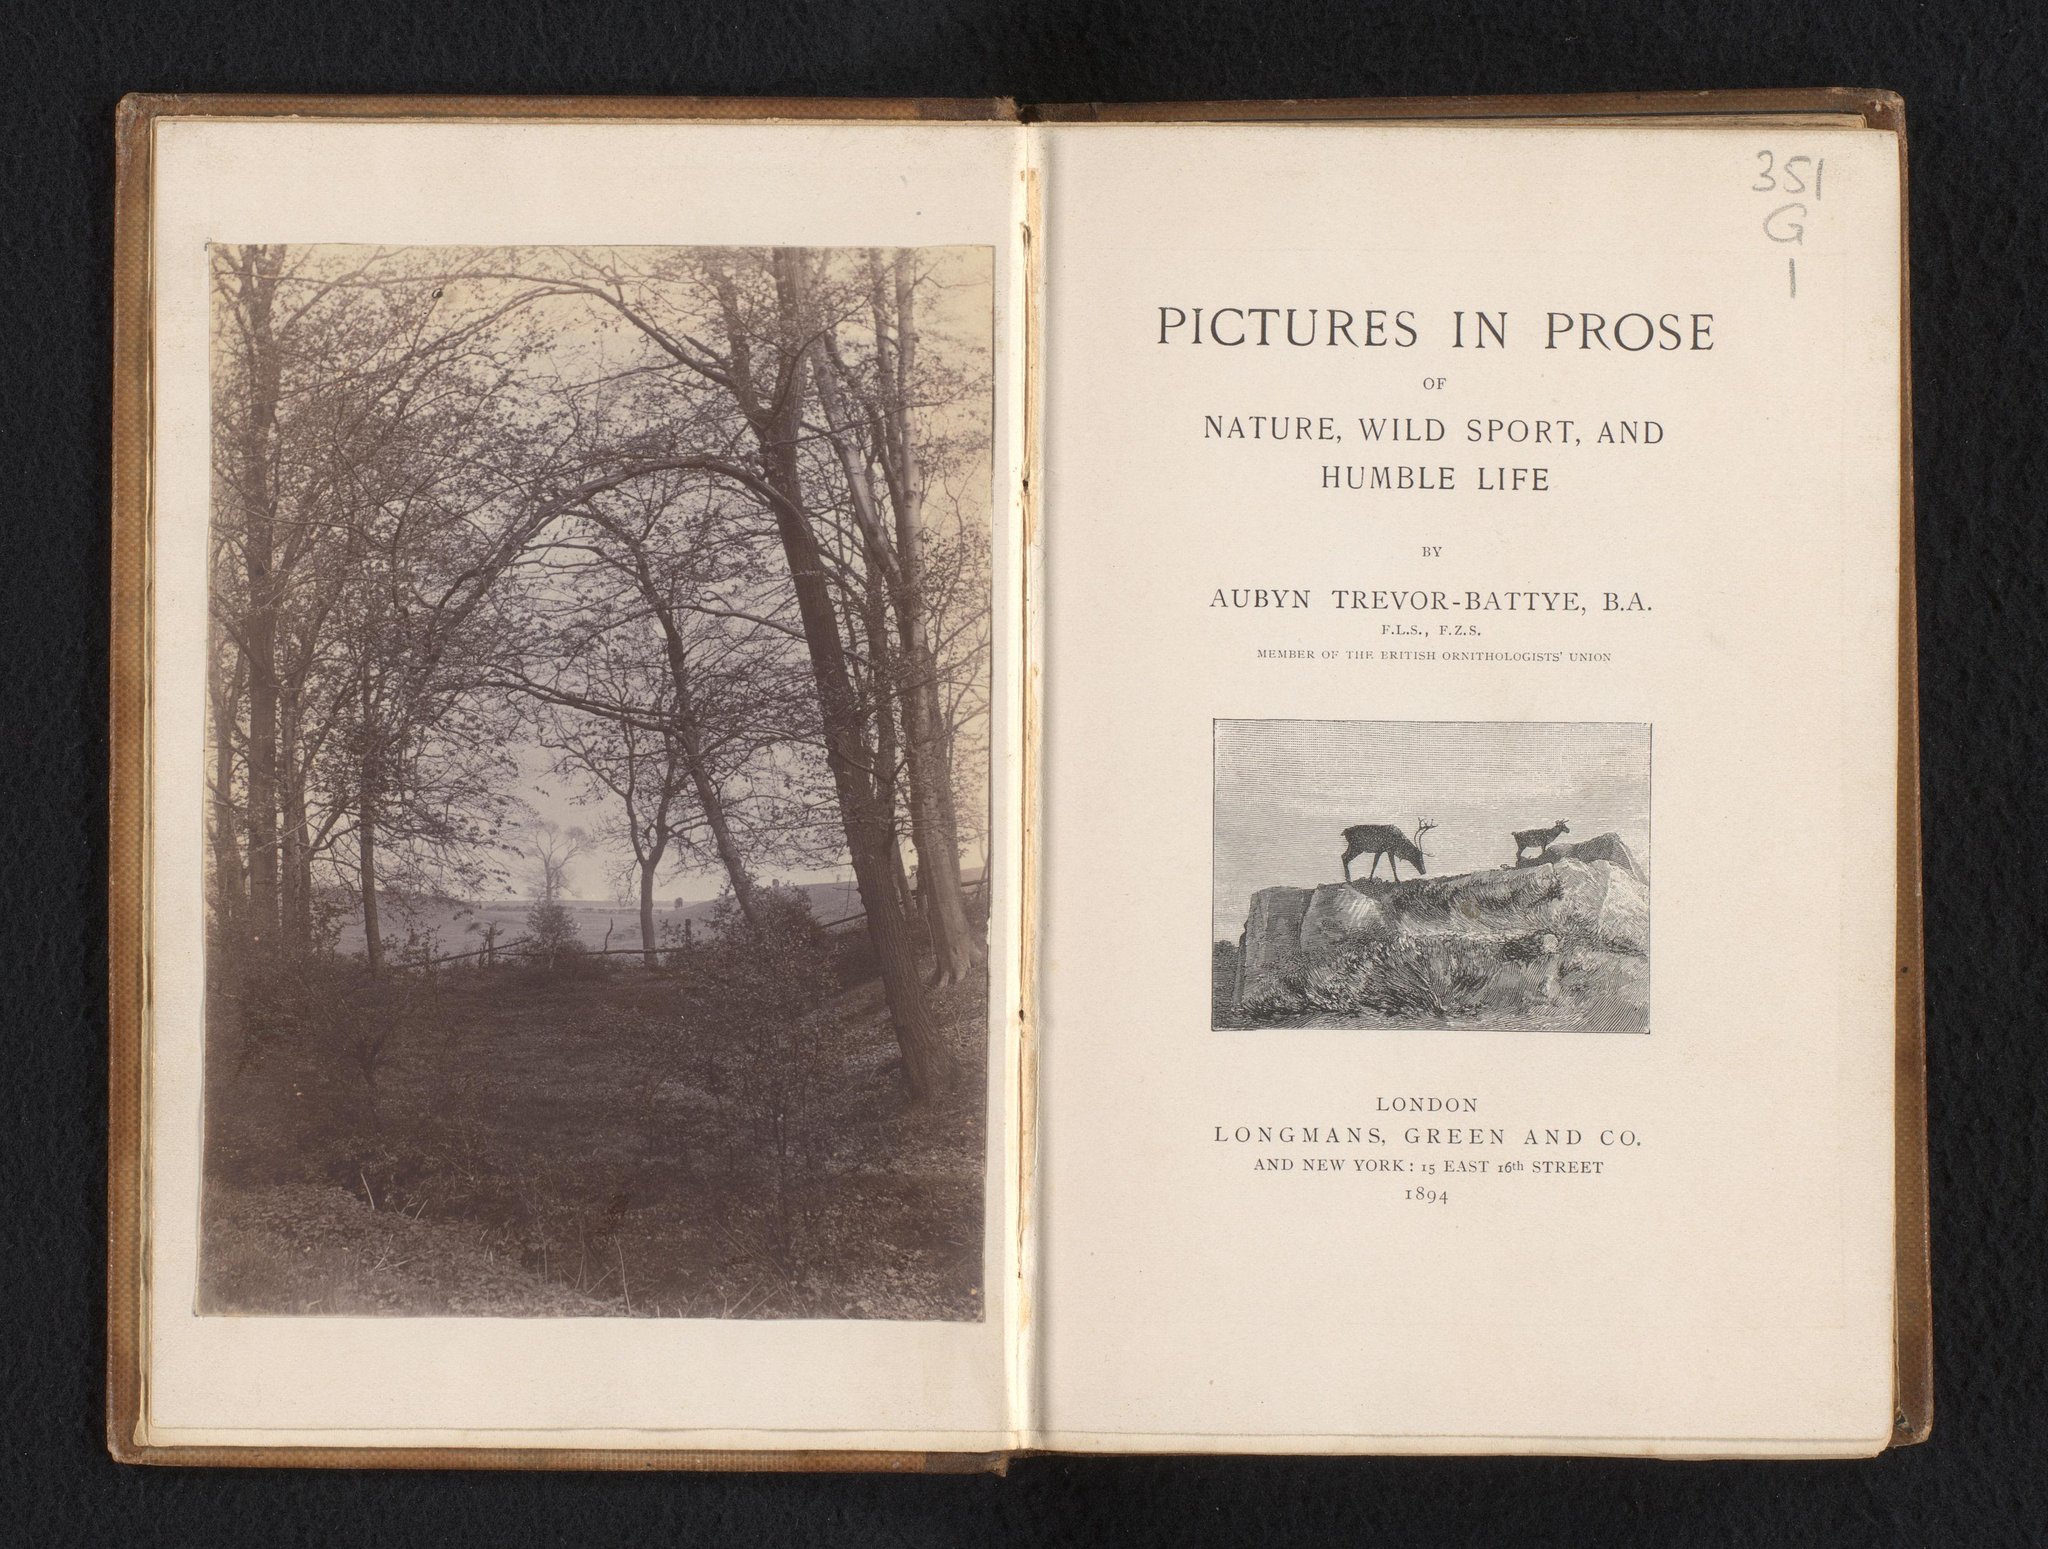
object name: book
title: Pictures in prose : of nature, wild sport, and humble life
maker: aubyn trevor-battye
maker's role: traveler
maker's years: 1855-1922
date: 1894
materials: paper, cardboard, linen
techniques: letterpress printing, rotogravure, salted paper print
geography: london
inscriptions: check stamp: ‘MUSSOORIE/ SANDHURST ROAD/ TUNBRIDGE WELLS.’, inscription: ‘JOHN CLIFFORD MILL, ESQ.’